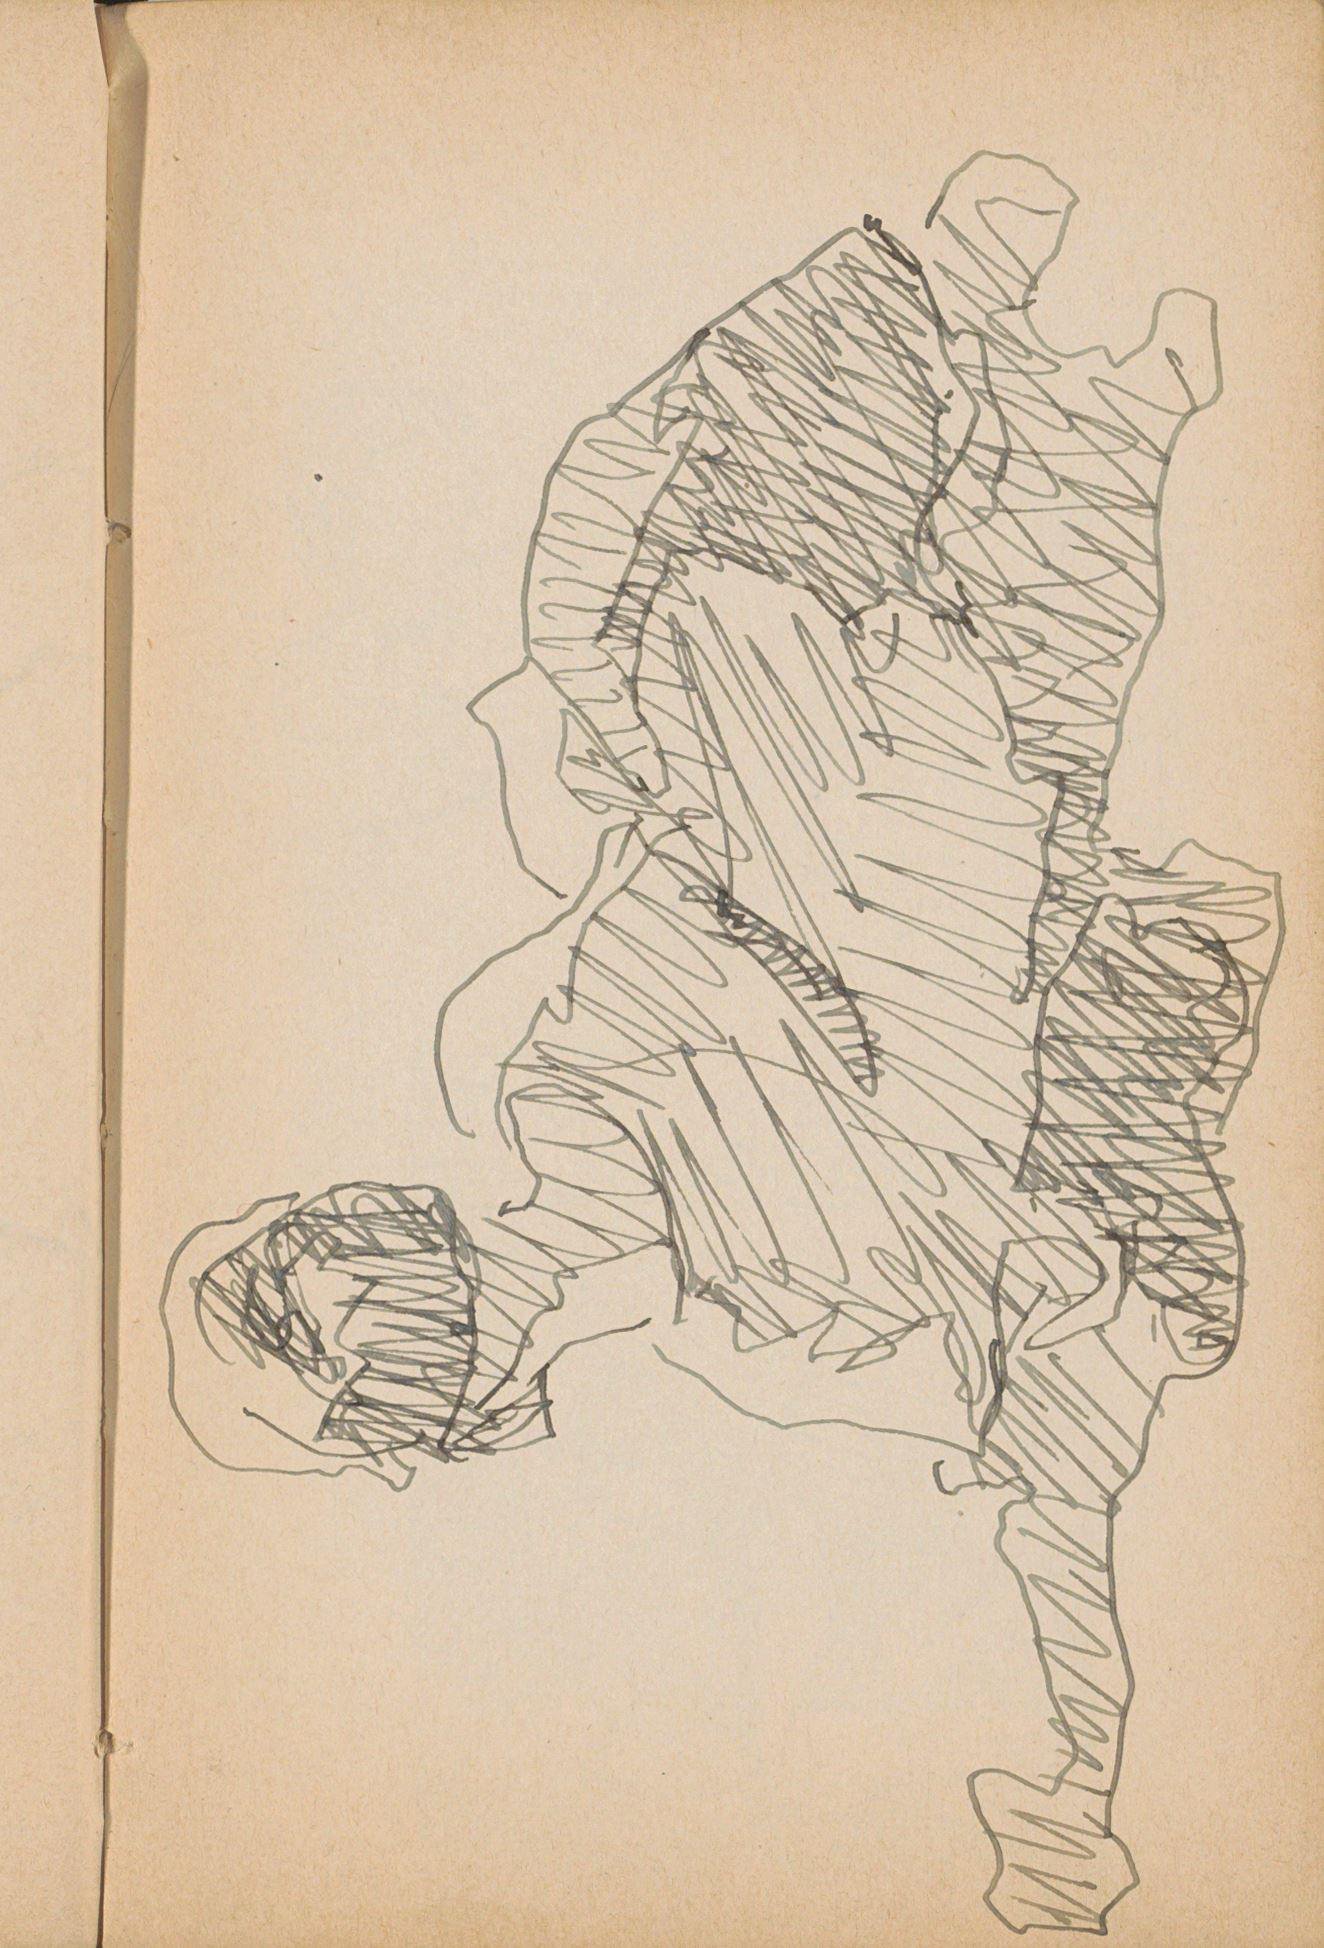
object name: sketchbook leaf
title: Figuurstudie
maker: reijer stolk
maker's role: draughtsman, print maker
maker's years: 1896-1945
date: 1908-1919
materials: ink, paper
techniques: pen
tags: anatomy (non-medical)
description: Blad 7 recto uit een schetsboek met 33 bladen.